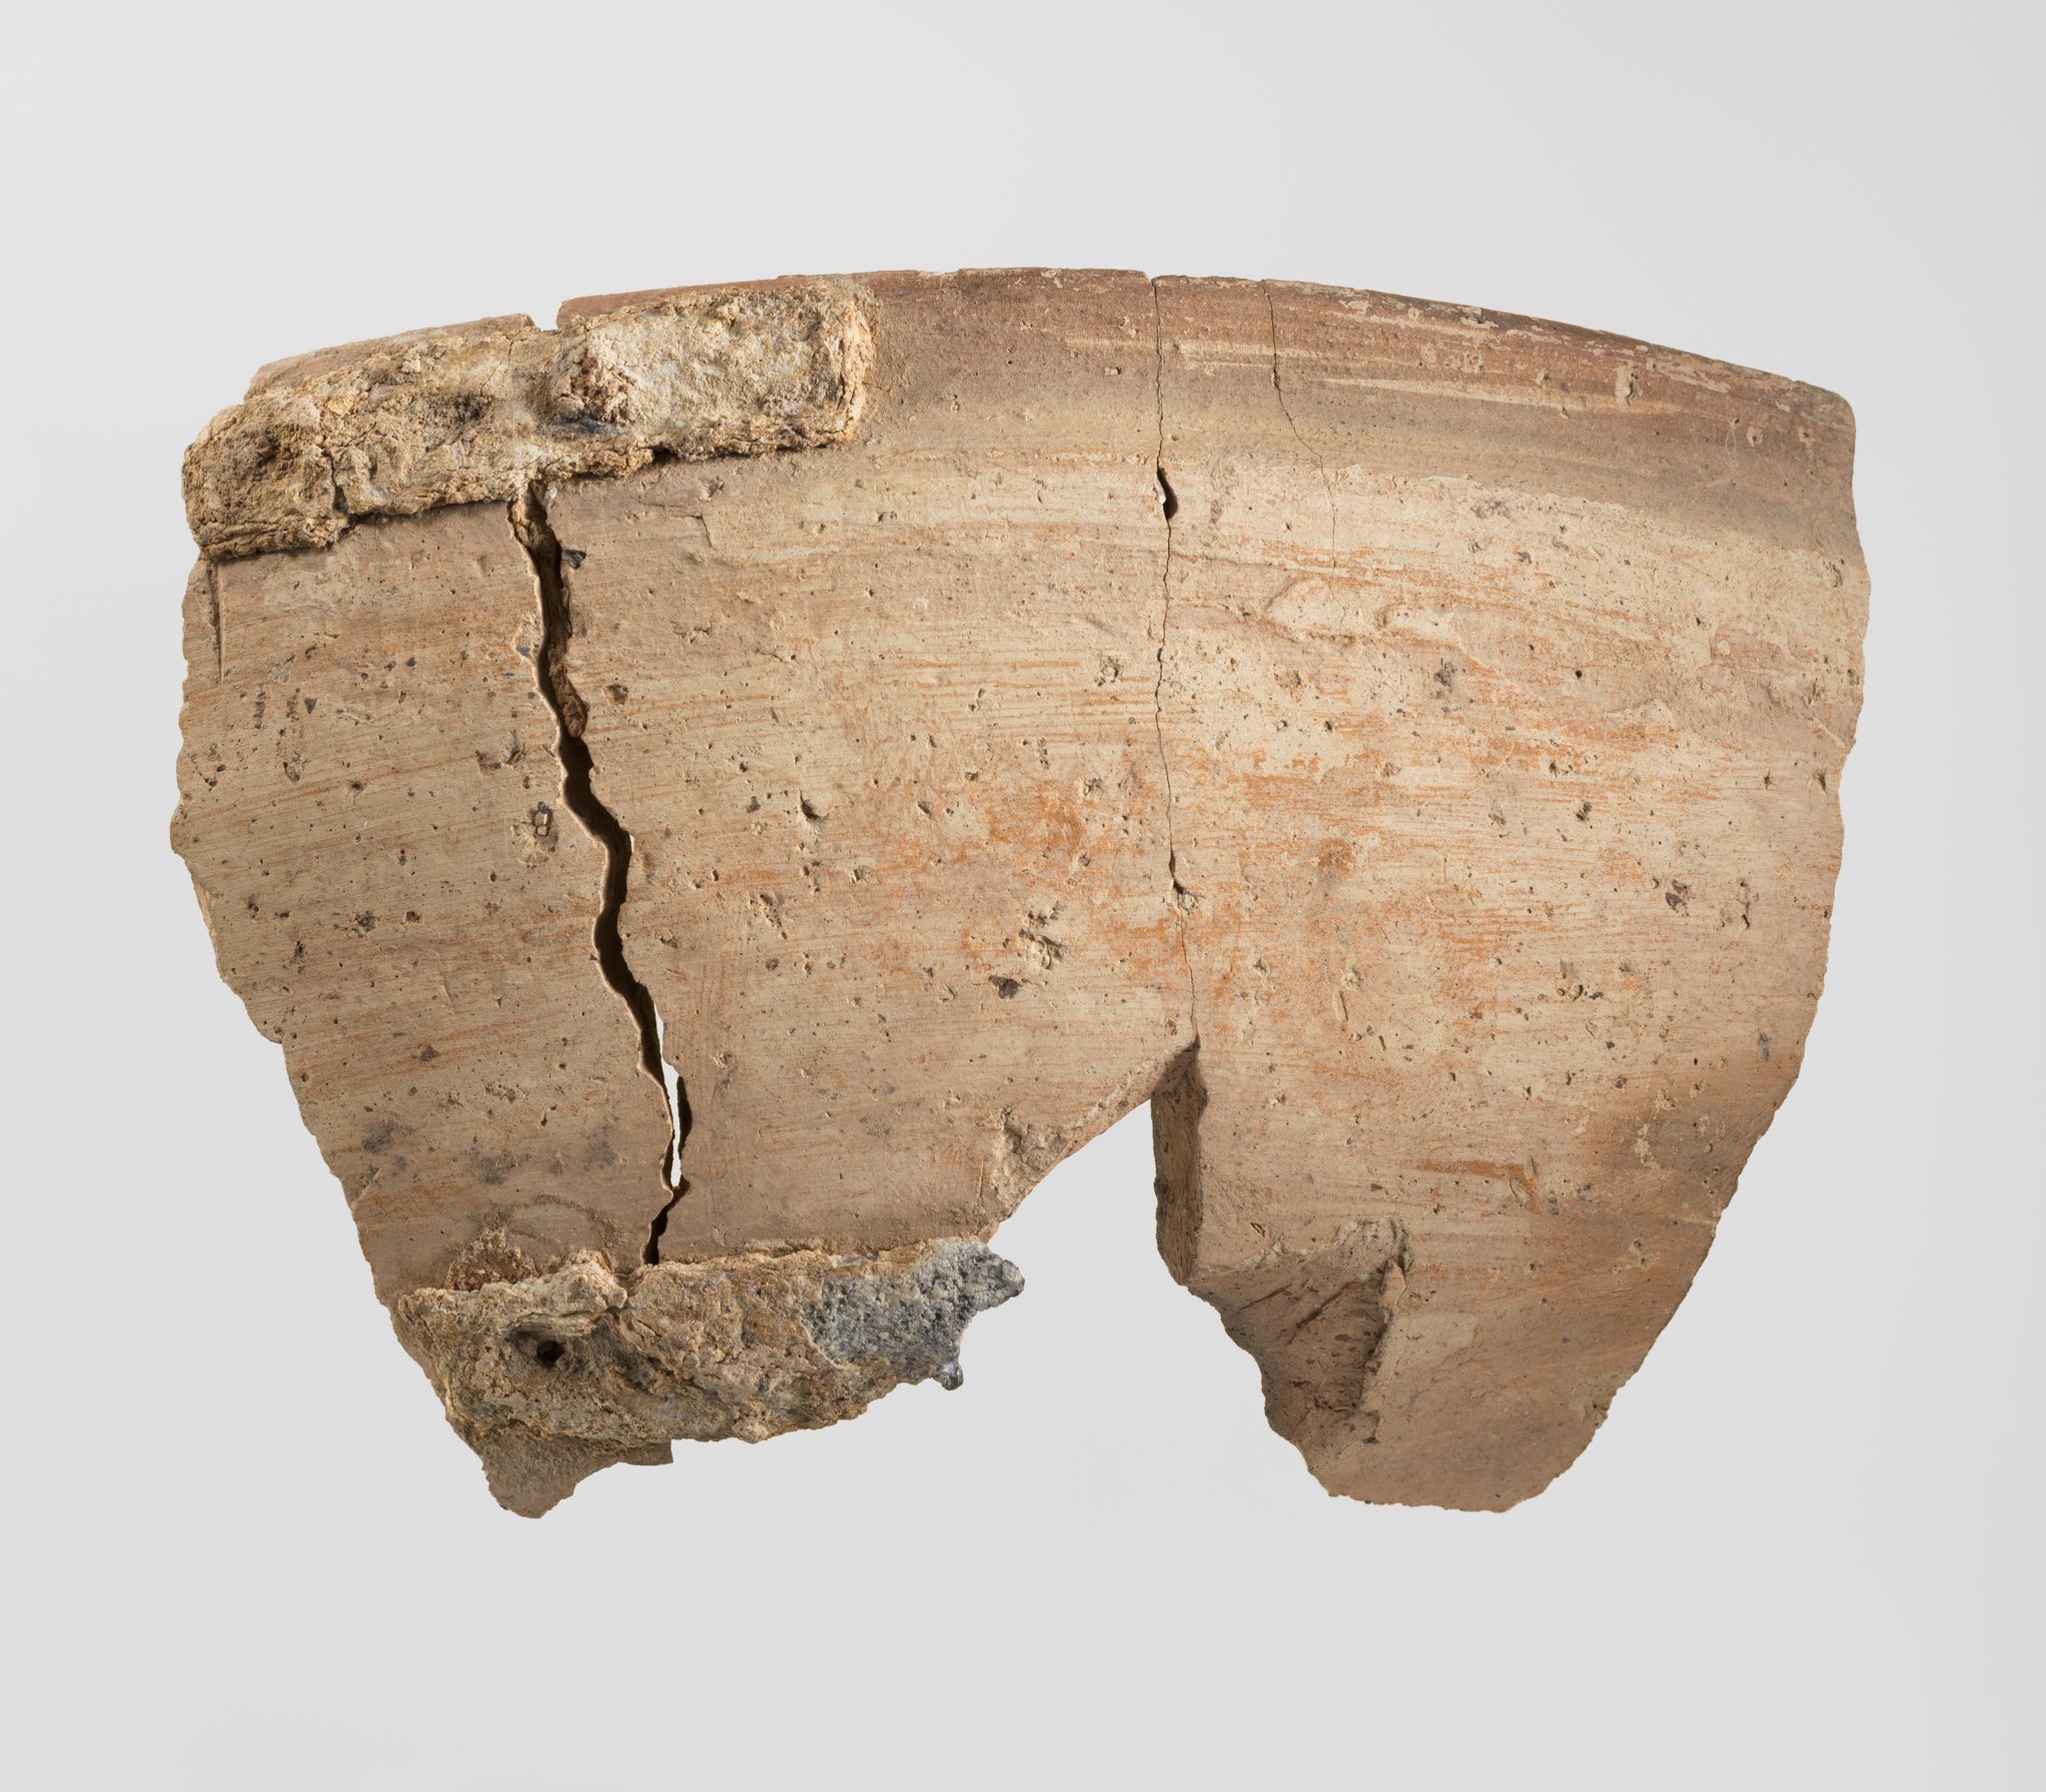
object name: bowl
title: Bowl sherd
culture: seleucid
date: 400-201 BCE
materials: ceramic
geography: iran